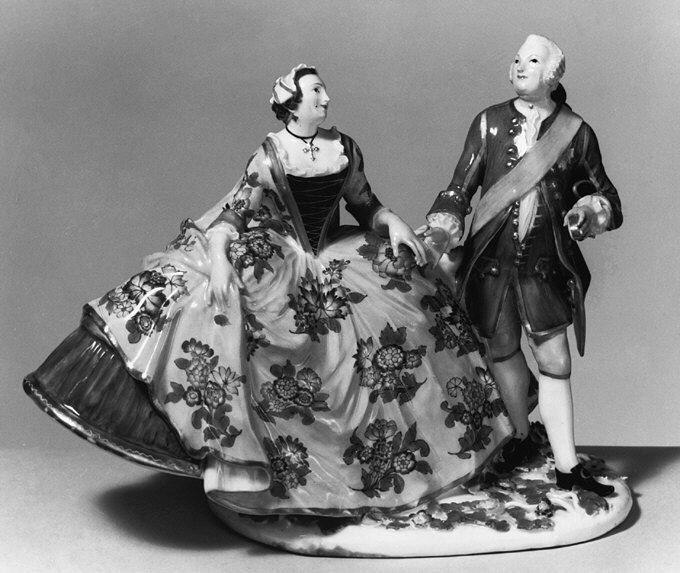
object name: group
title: Cavalier and lady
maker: meissen manufactory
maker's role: manufactory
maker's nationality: german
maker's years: 1710-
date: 1744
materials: hard paste porcelain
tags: men,women,flowers